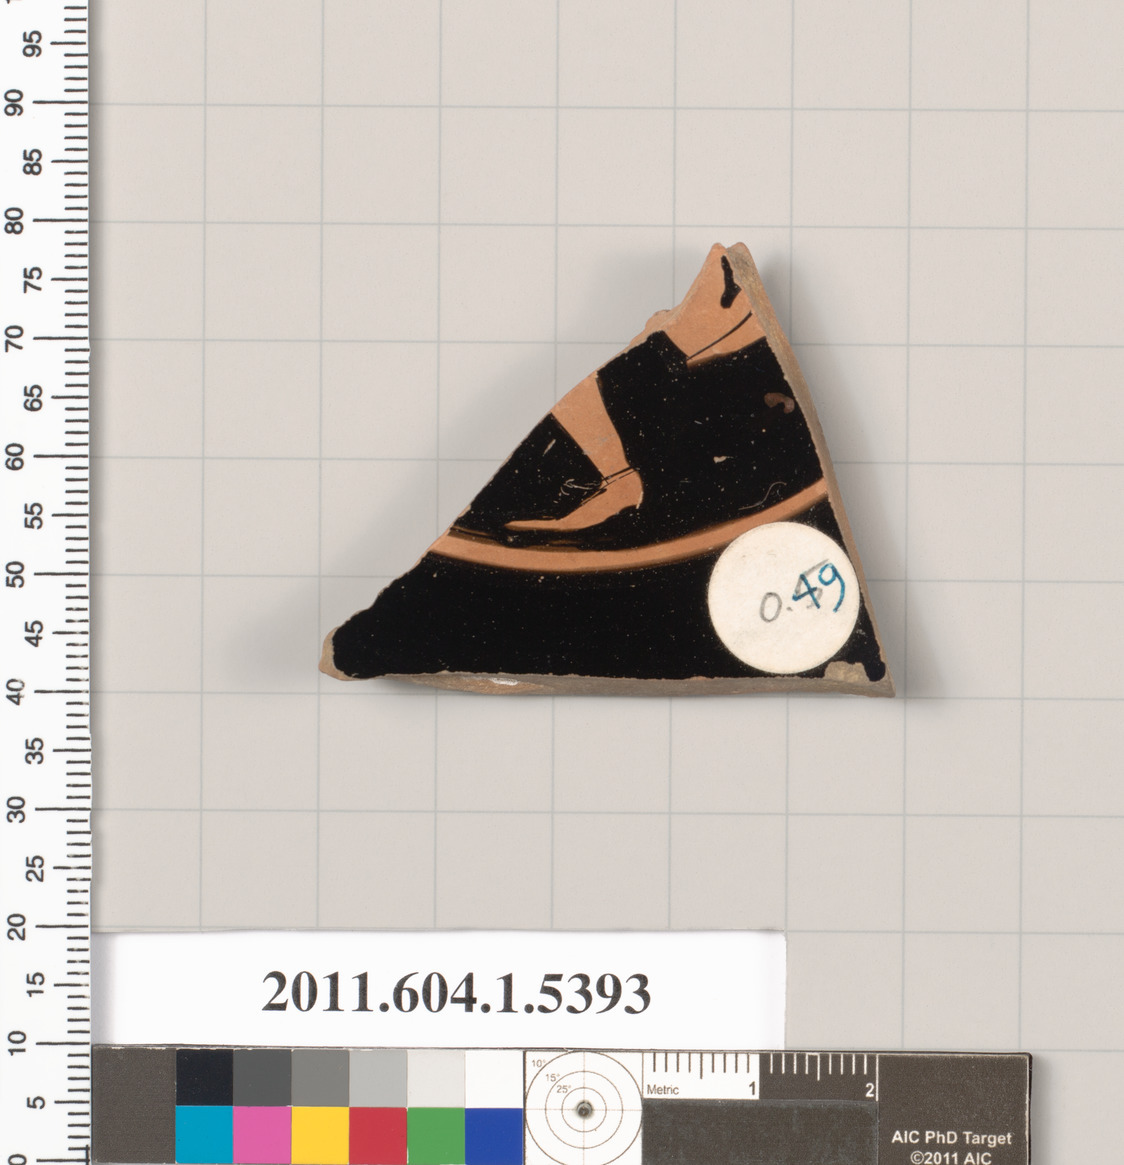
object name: kylix fragment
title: Terracotta fragment of a kylix (drinking cup)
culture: greek, attic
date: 520-510 BCE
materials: terracotta